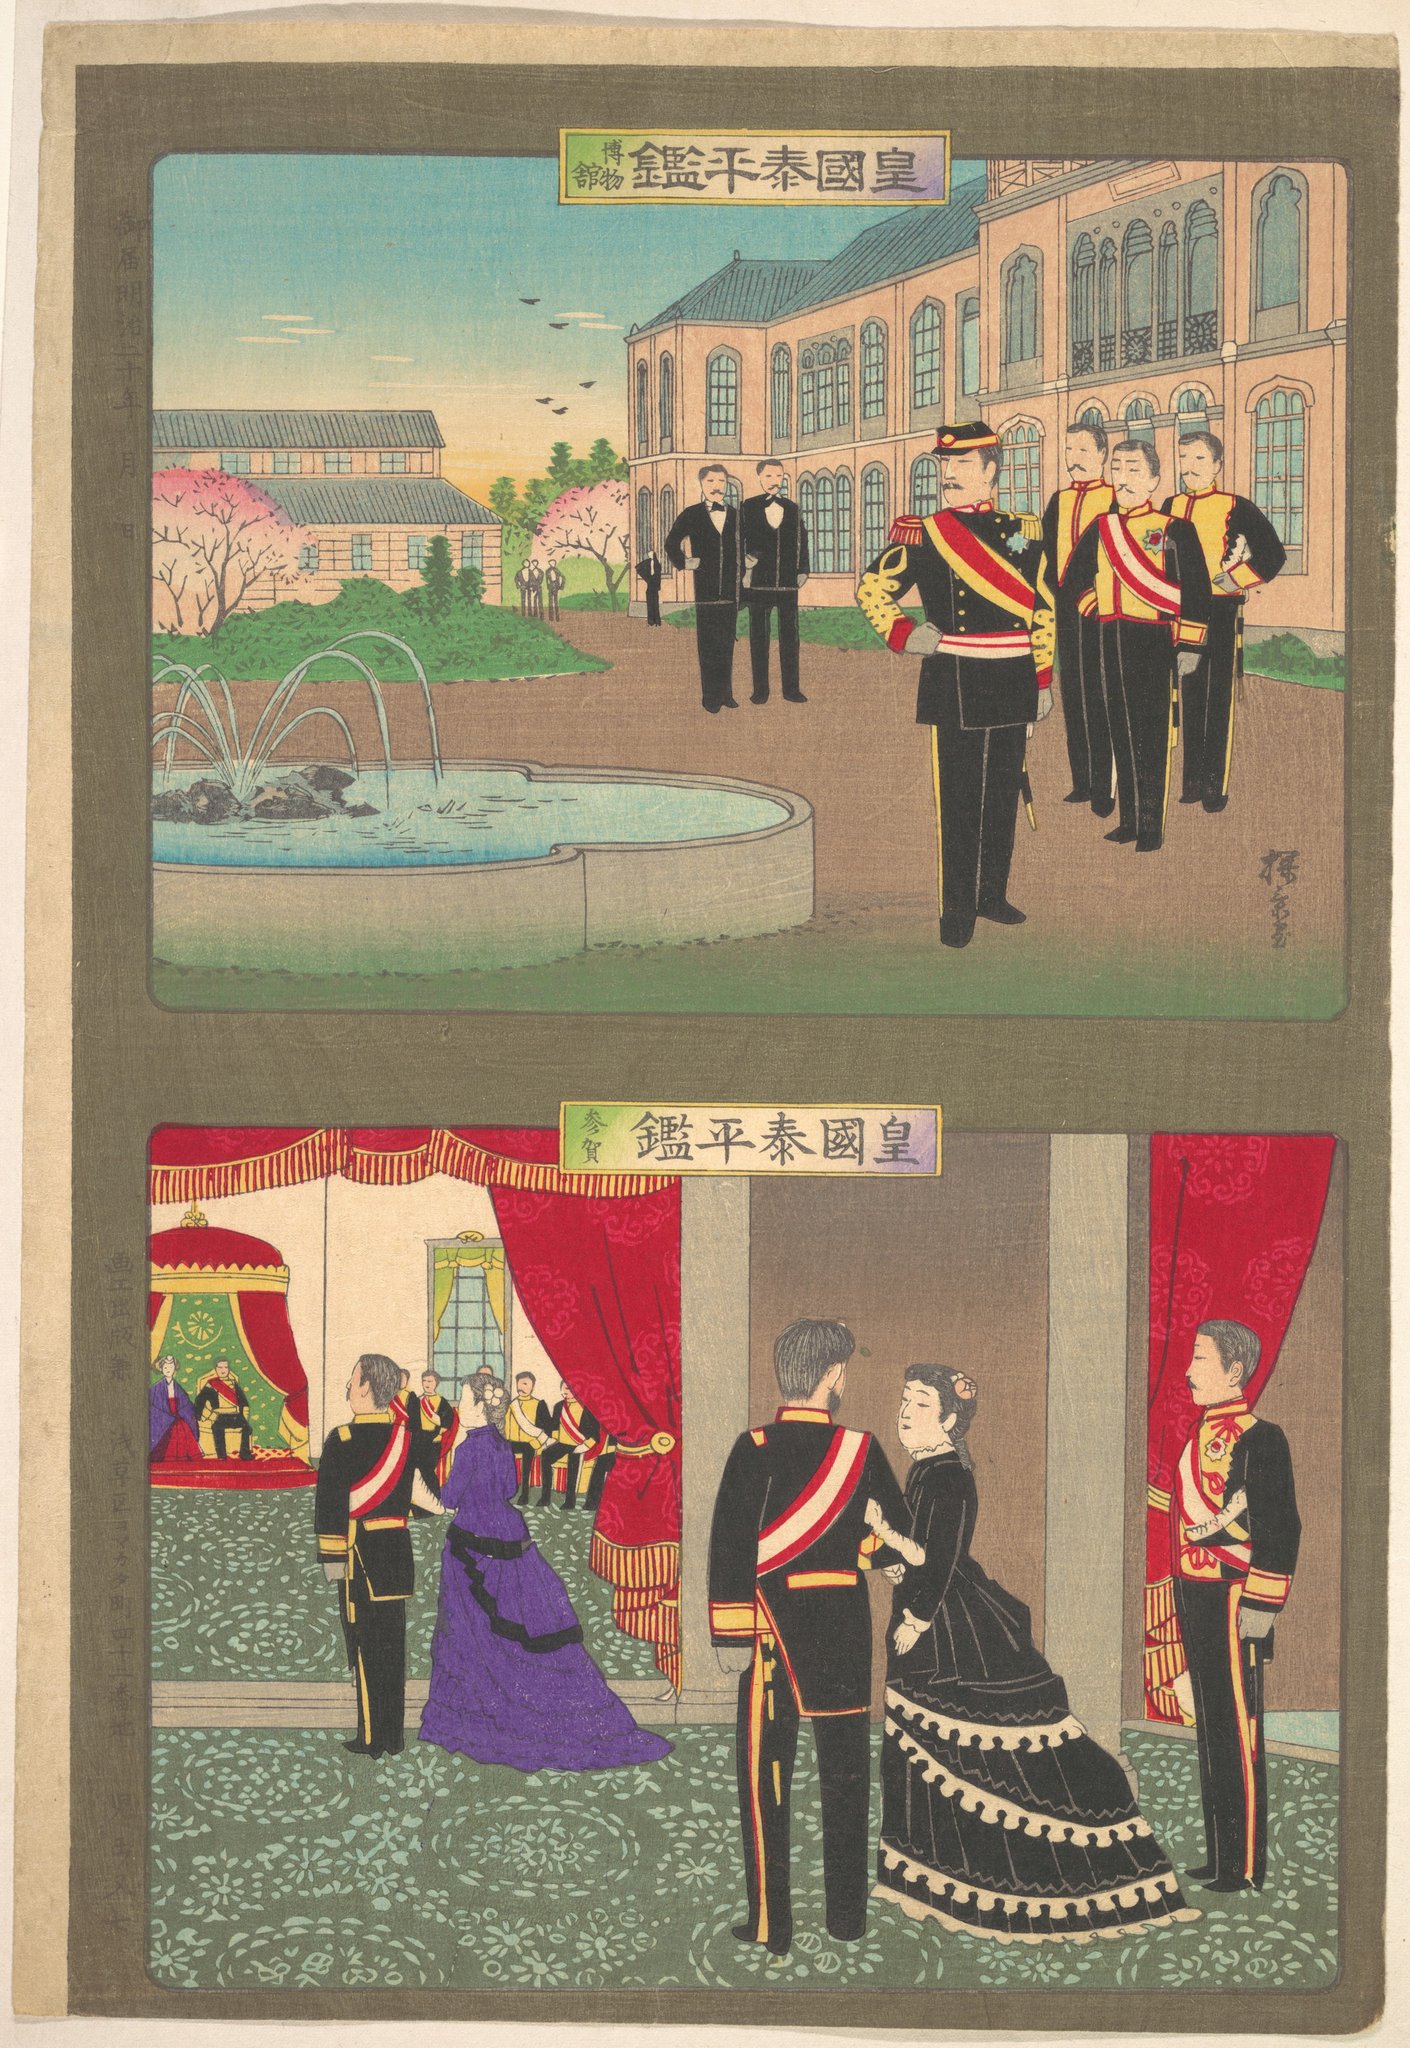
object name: print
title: Example of Peaceful Empire – Museum, Congratulatory Palace Visit (Kōkoku Taihei Kagami – Hakubutsukan, Sanga)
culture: japanese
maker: utagawa kunisada iii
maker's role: artist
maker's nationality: japanese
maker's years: 1848-1920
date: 1887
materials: ink, paper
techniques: woodblock print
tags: fountains,palaces,men,women